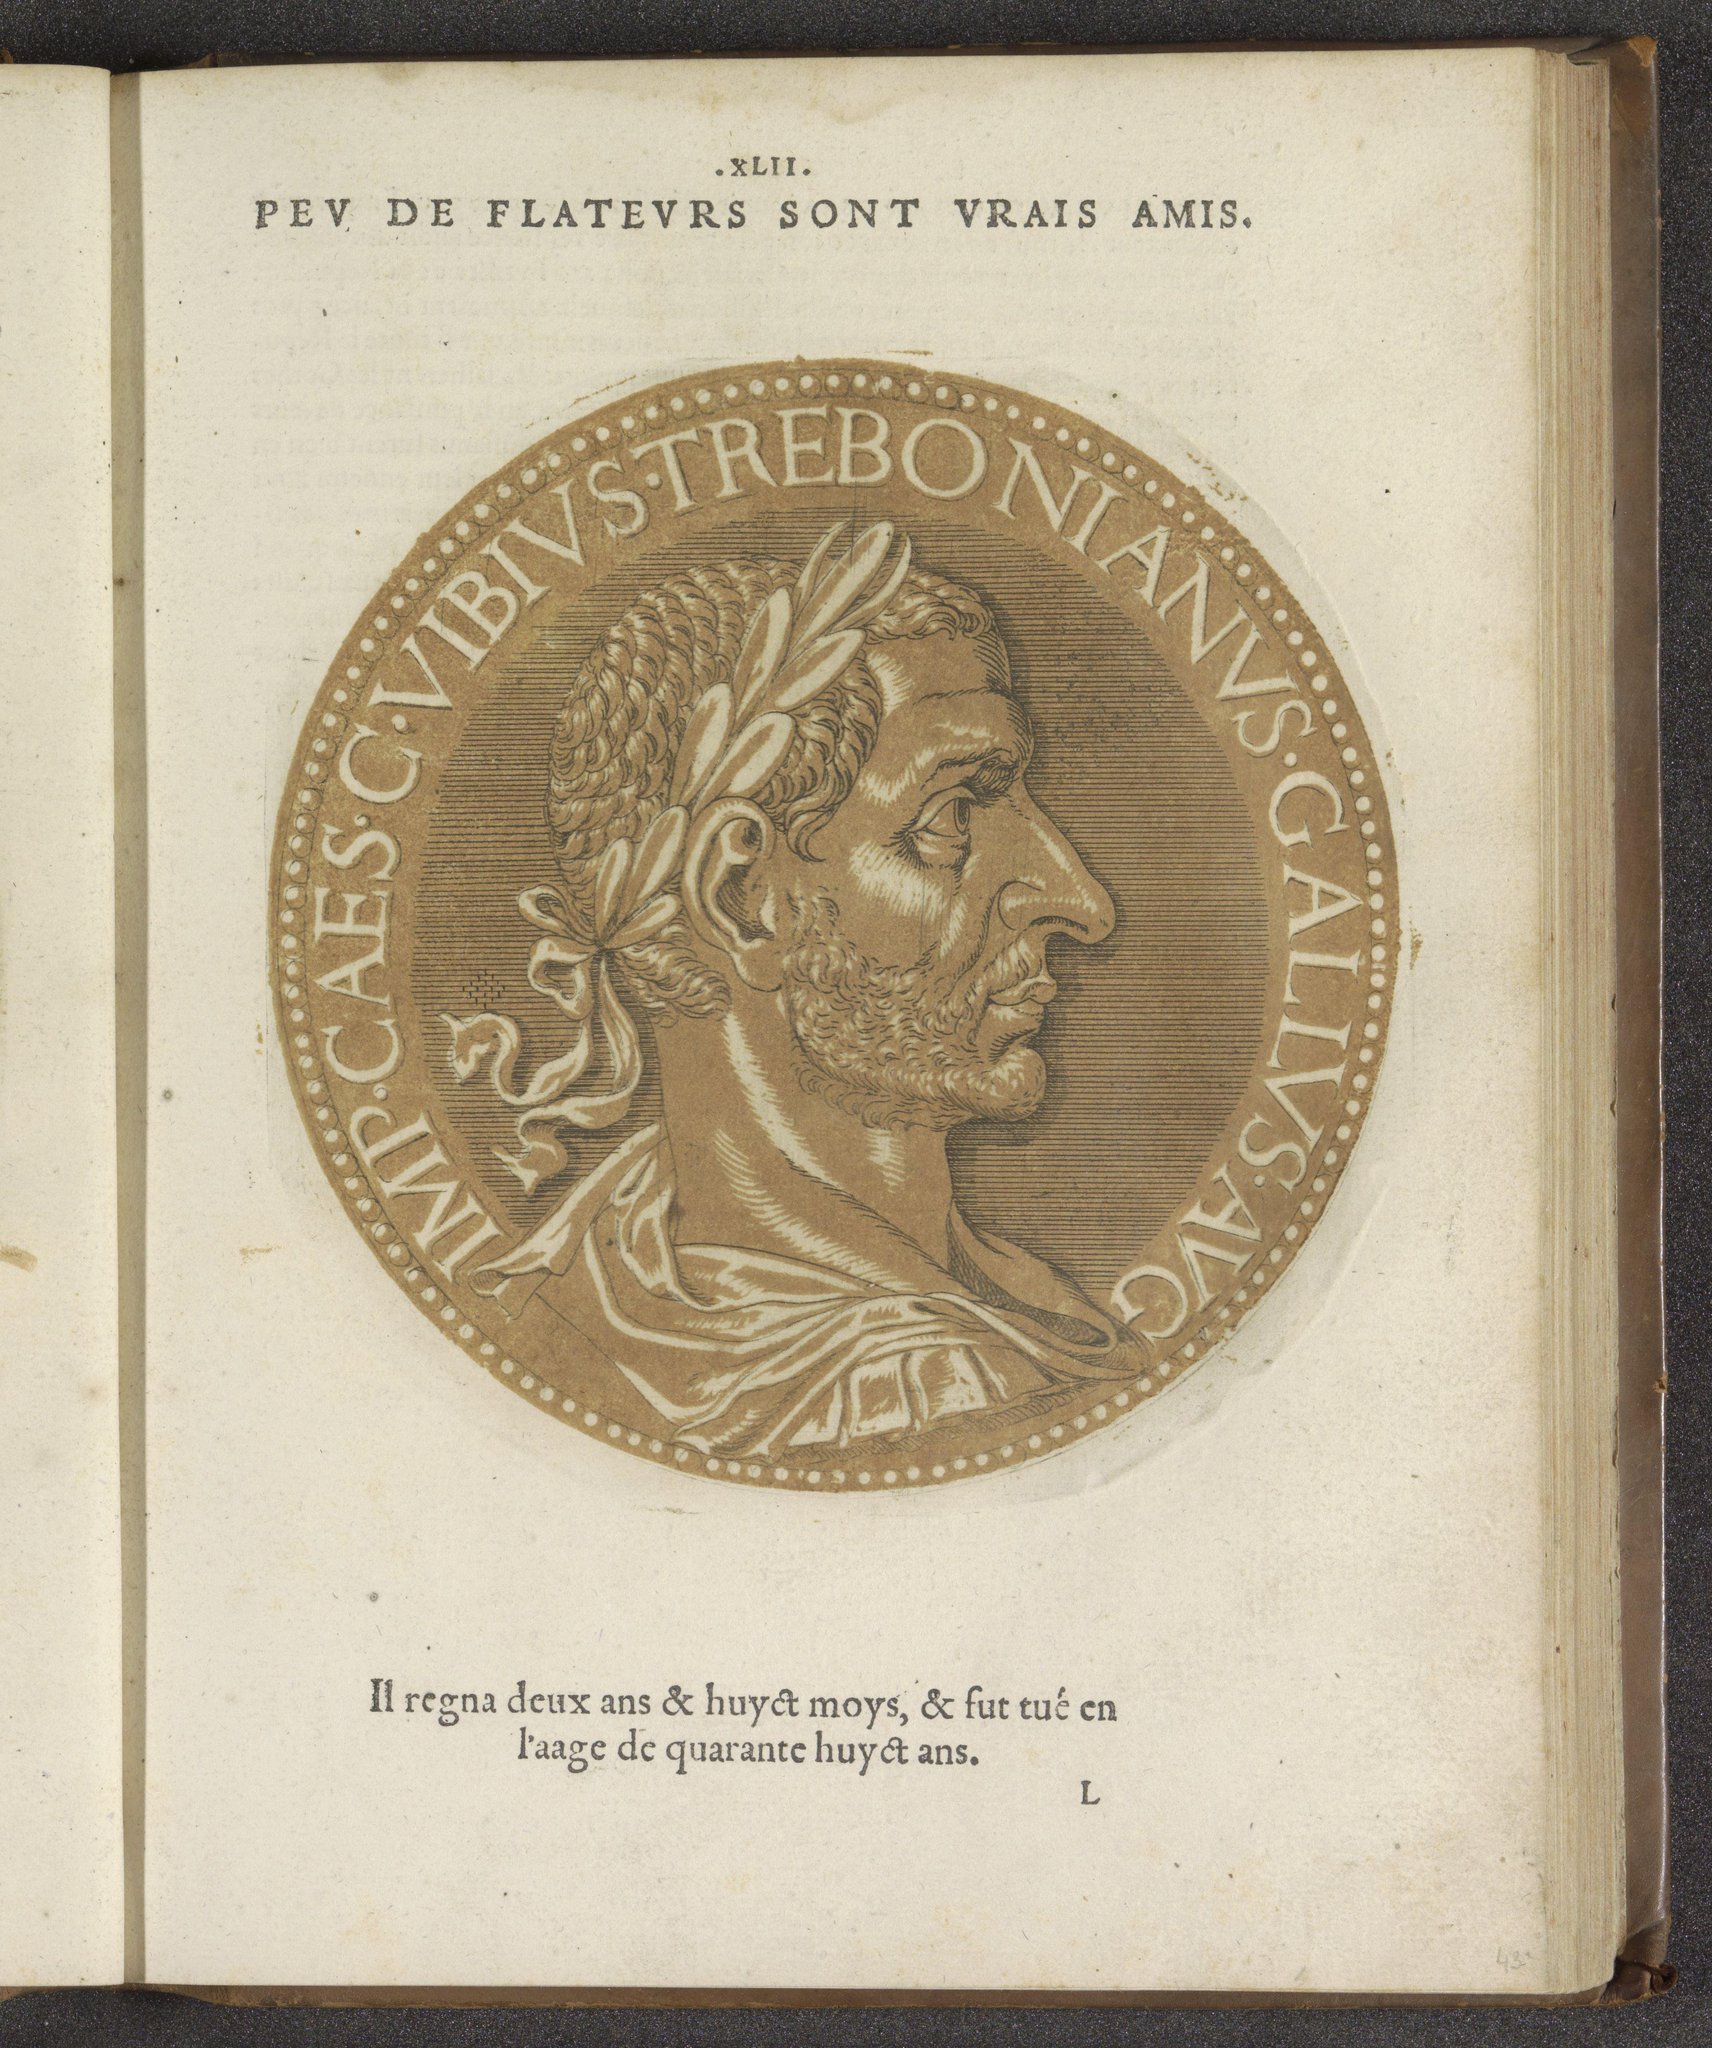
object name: page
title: Portret van keizer Trebonianus Gallus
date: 1557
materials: paper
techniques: woodcut, etching, letterpress printing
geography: antwerp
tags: emperor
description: Portret van keizer Trebonianus Gallus, op een munt met randschrift. De prent maakt deel uit van een boek over de keizers vanaf Julius Caesar tot en met Karel V en zijn broer Ferdinand.